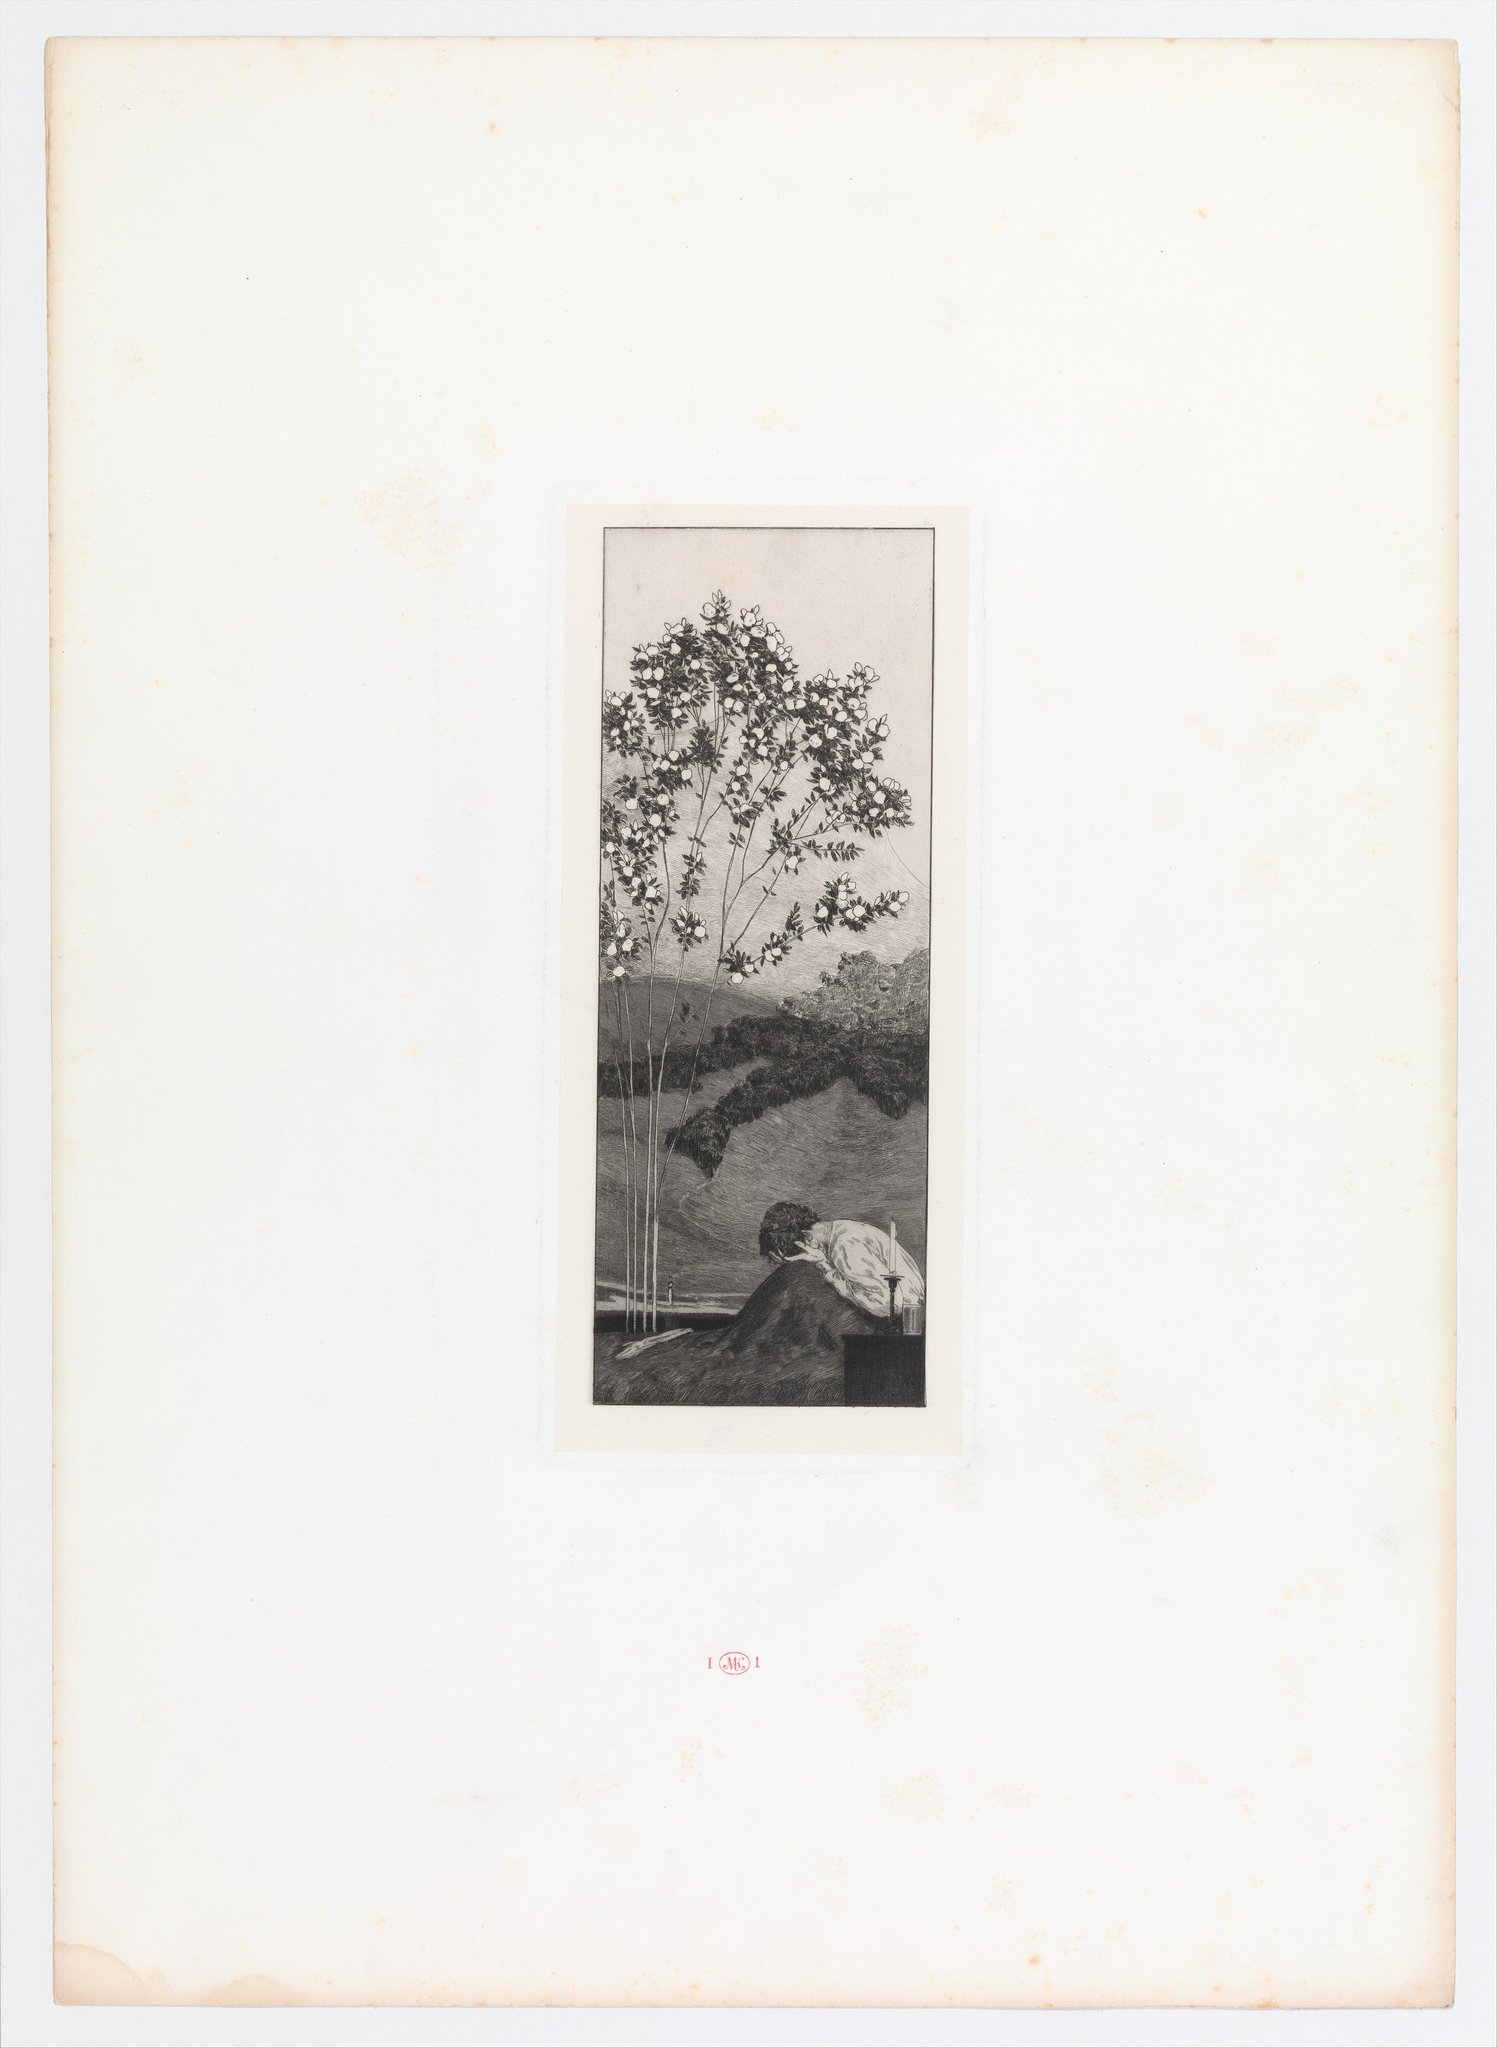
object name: print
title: Wünsche (Yearnings) from Ein Handschuh (A Glove). Cyclus von zehn Compositionen radirt. Rad. Opus VI, Plate III. First edition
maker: max klinger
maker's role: artist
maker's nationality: german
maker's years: 1857-1920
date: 1881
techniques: aquatint, printmaking, drypoint, etching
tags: human figures,trees